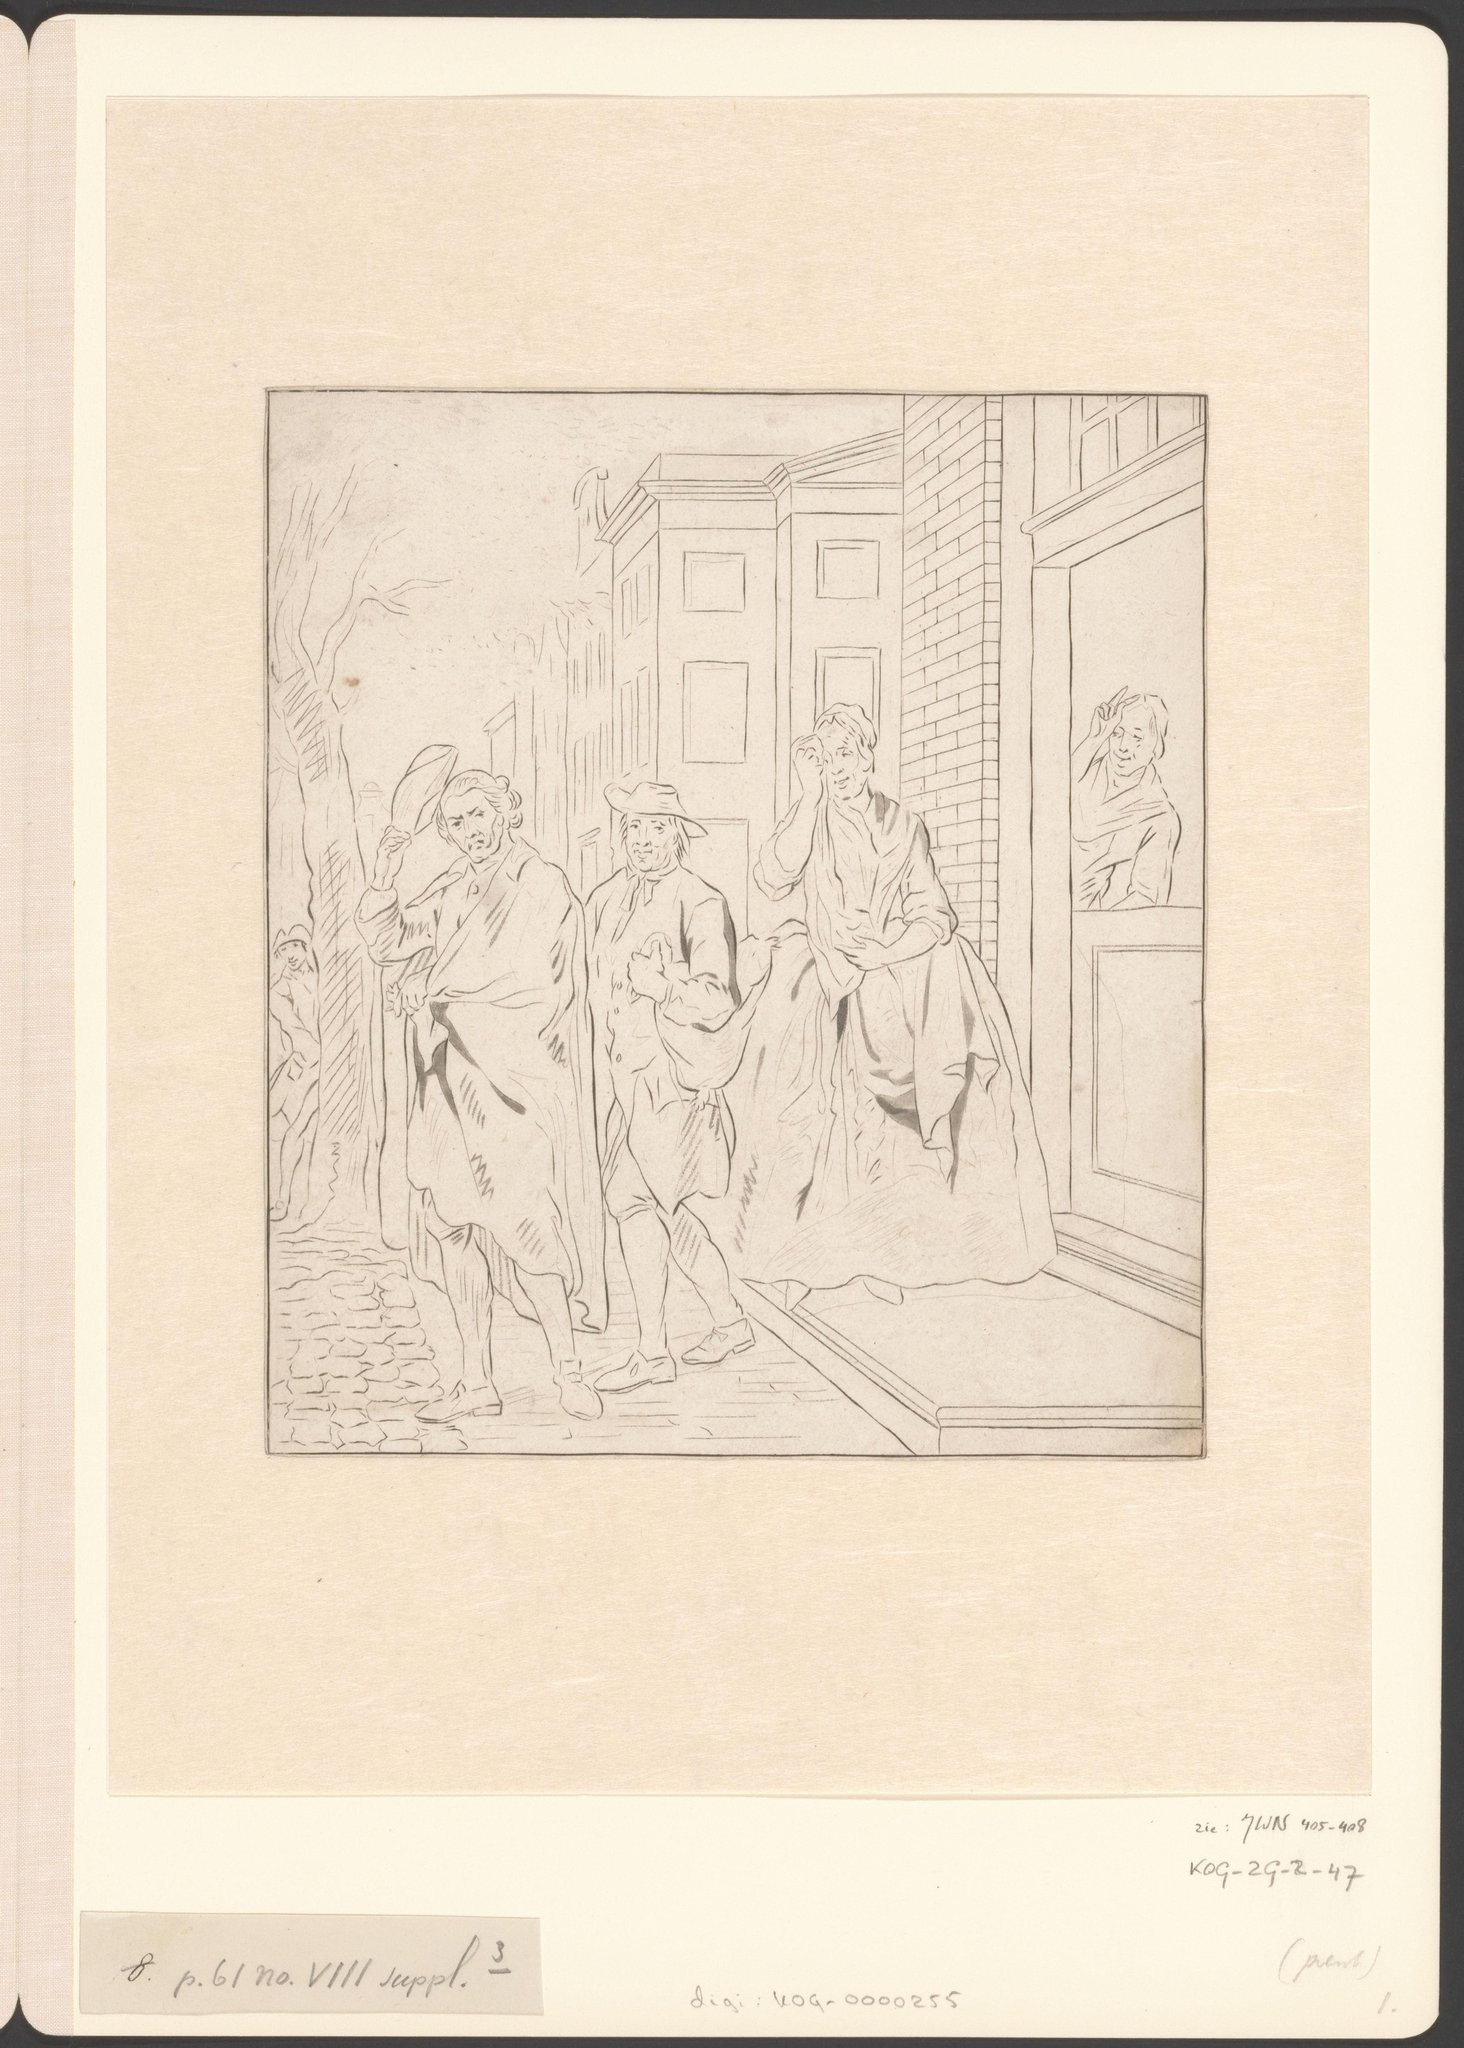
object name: print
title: De Valse Schijndeugd Ontdekt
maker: benjamin martini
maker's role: print maker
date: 1777-1780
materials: paper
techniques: aquatint, etching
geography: amsterdam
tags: morphology of facial expression (+ being sad, suffering, sorrowing), taking leave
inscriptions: collector's mark: Lugt 2488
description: 'De Geveinsde Droefheid': eerste bedrijf, elfde toneel van het blijspel 'De Ontdekte Schijndeugd' van David Lingelbach (1687). Een vrouw (Geertruy) staande in de deuropening veinst droefheid bij het vertrek van haar oudere man (Filibert), die door een jonge man wordt weggeleid.